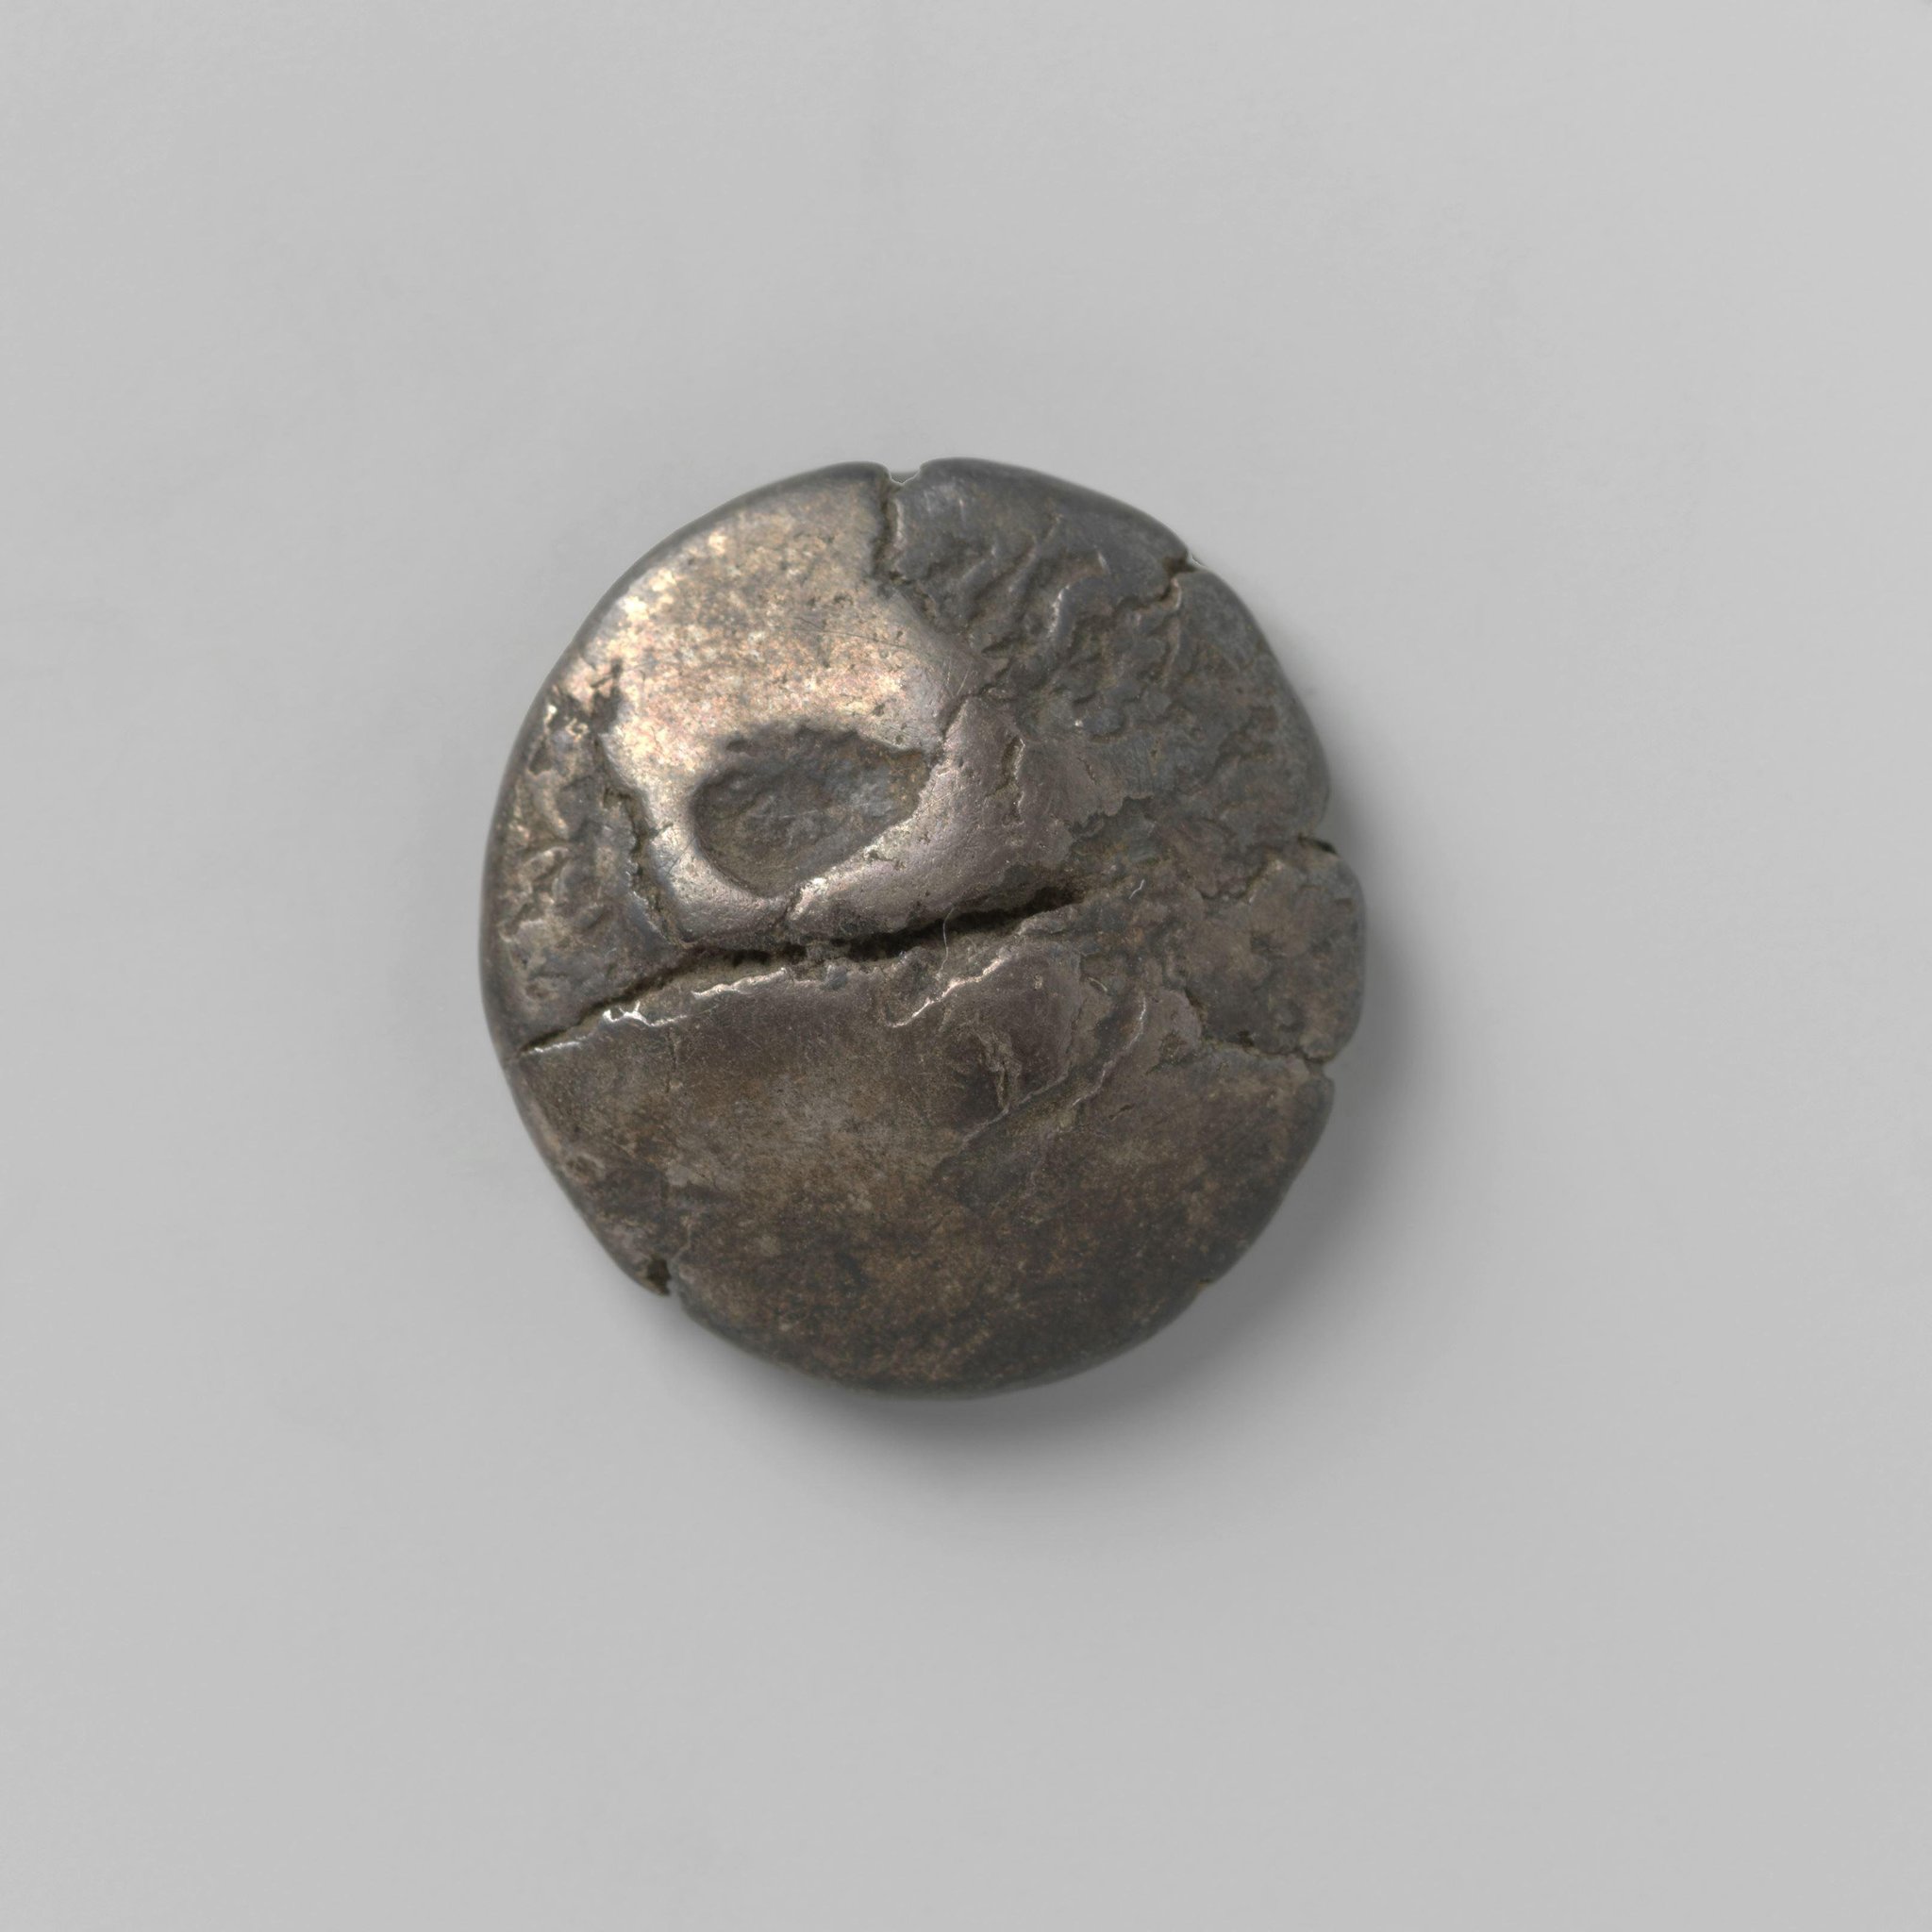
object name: coin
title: Djampel van koninkrijk Majopahit, hindoerijk op] Java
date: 1290-1520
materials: silver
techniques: striking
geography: java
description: Zilveren schotelvormige munt. Voorzijde: letterteken in devanagari-schrift [maa?]. Keerzijde, figuratie [bloem?].